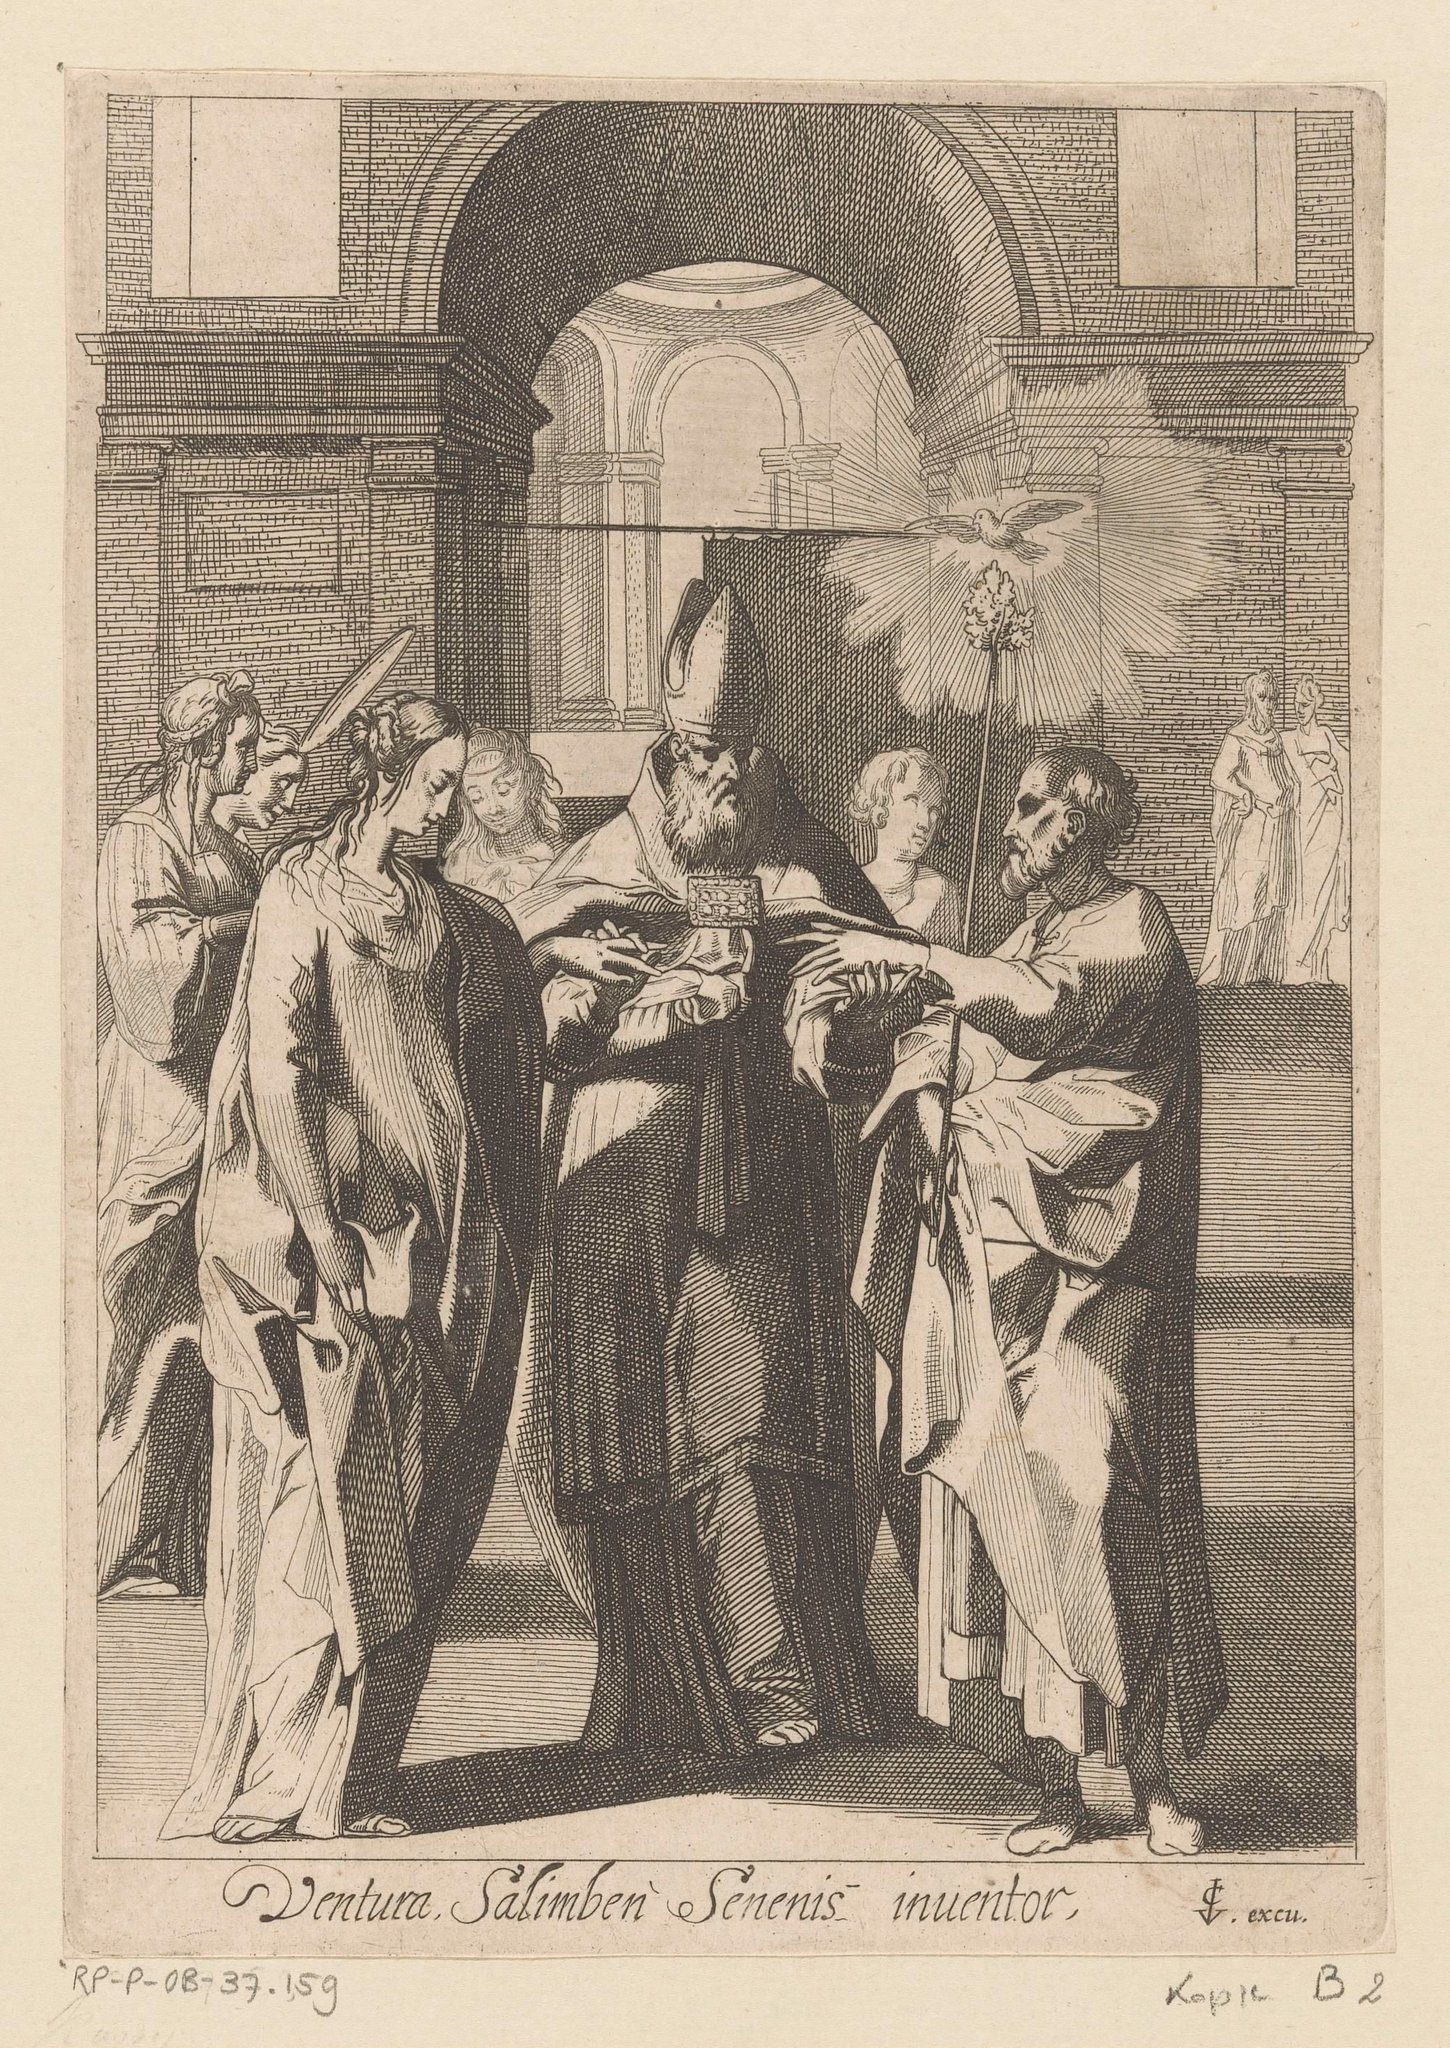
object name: print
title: Het huwelijk van Maria met Jozef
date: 1601-1652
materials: paper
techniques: etching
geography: italy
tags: marriage of mary and joseph, 'sposalizio': they are married by the high priest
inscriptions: collector's mark: Lugt 240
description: Maria en Jozef worden door een hogepriester in de echt verbonden. Jozef houdt in zijn hand een tak met bladeren, waarboven de Heilige Geest in de gedaante van een duif zweeft.